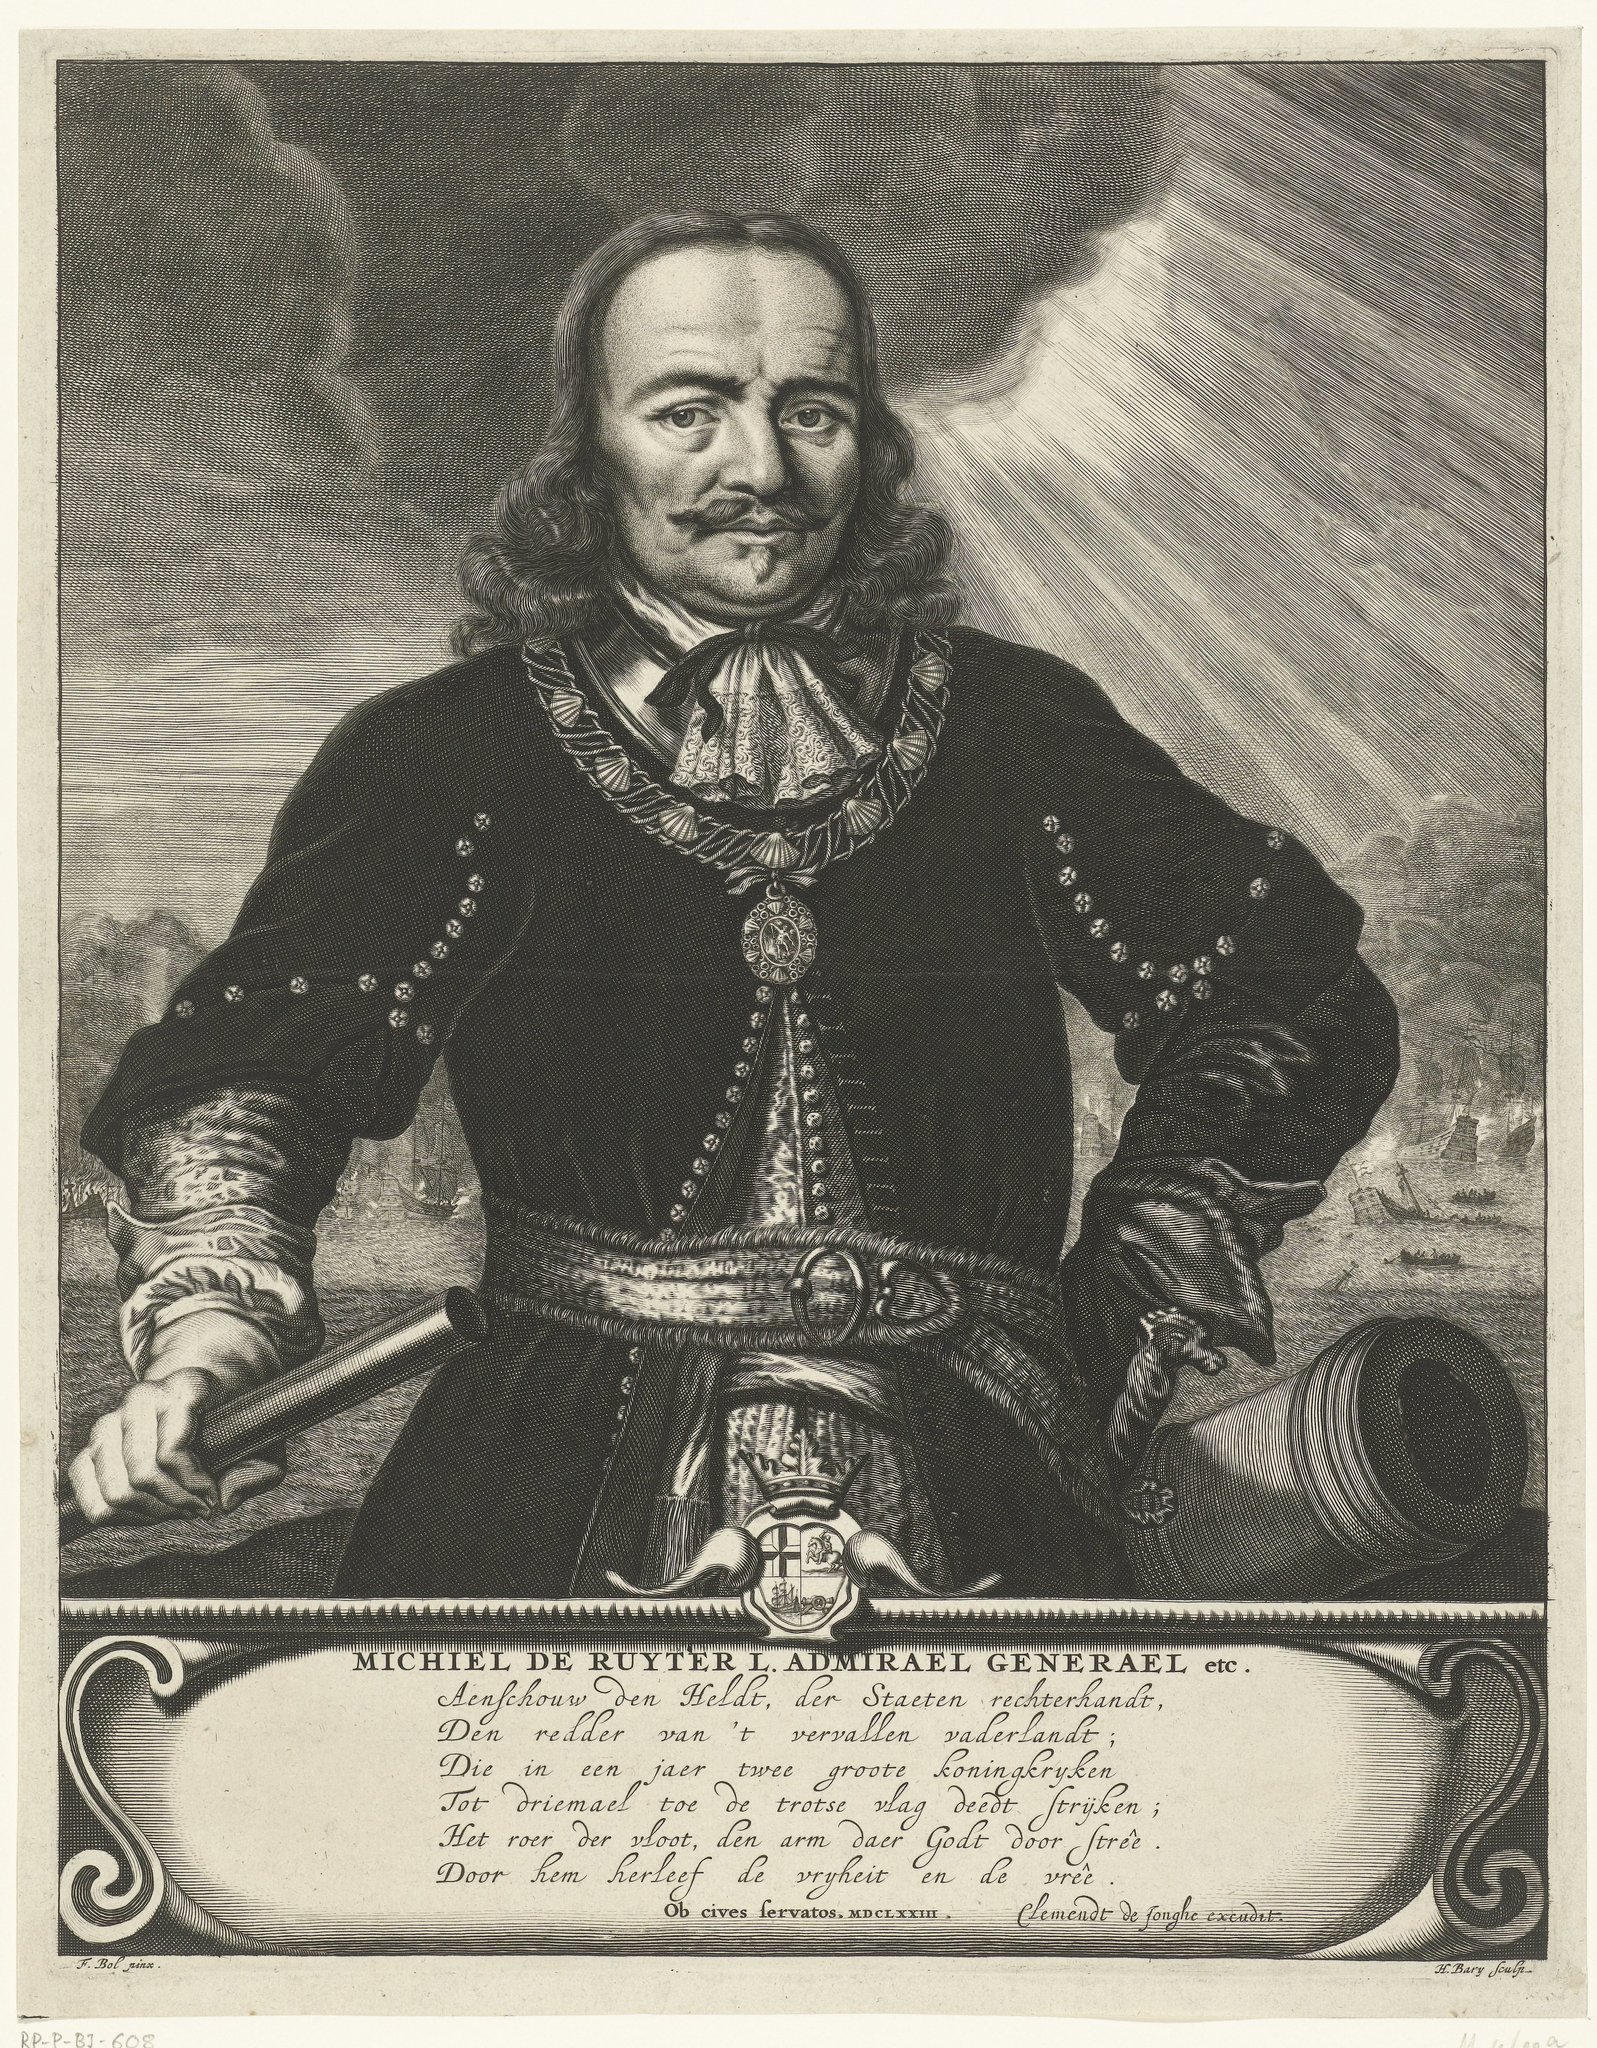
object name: print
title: Portret van Michiel Adriaenszoon de Ruyter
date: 1673-1707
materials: paper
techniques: engraving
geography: netherlands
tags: flushing, michiel adriaenszoon de ruyter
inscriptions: collector's mark: Lugt 240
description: Portret van admiraal Michiel Adriaenszoon de Ruyter met de commandostaf in zijn hand. Op de achtergrond een zeegevecht. Onder het portret een lofdicht van zes regels in het Nederlands.